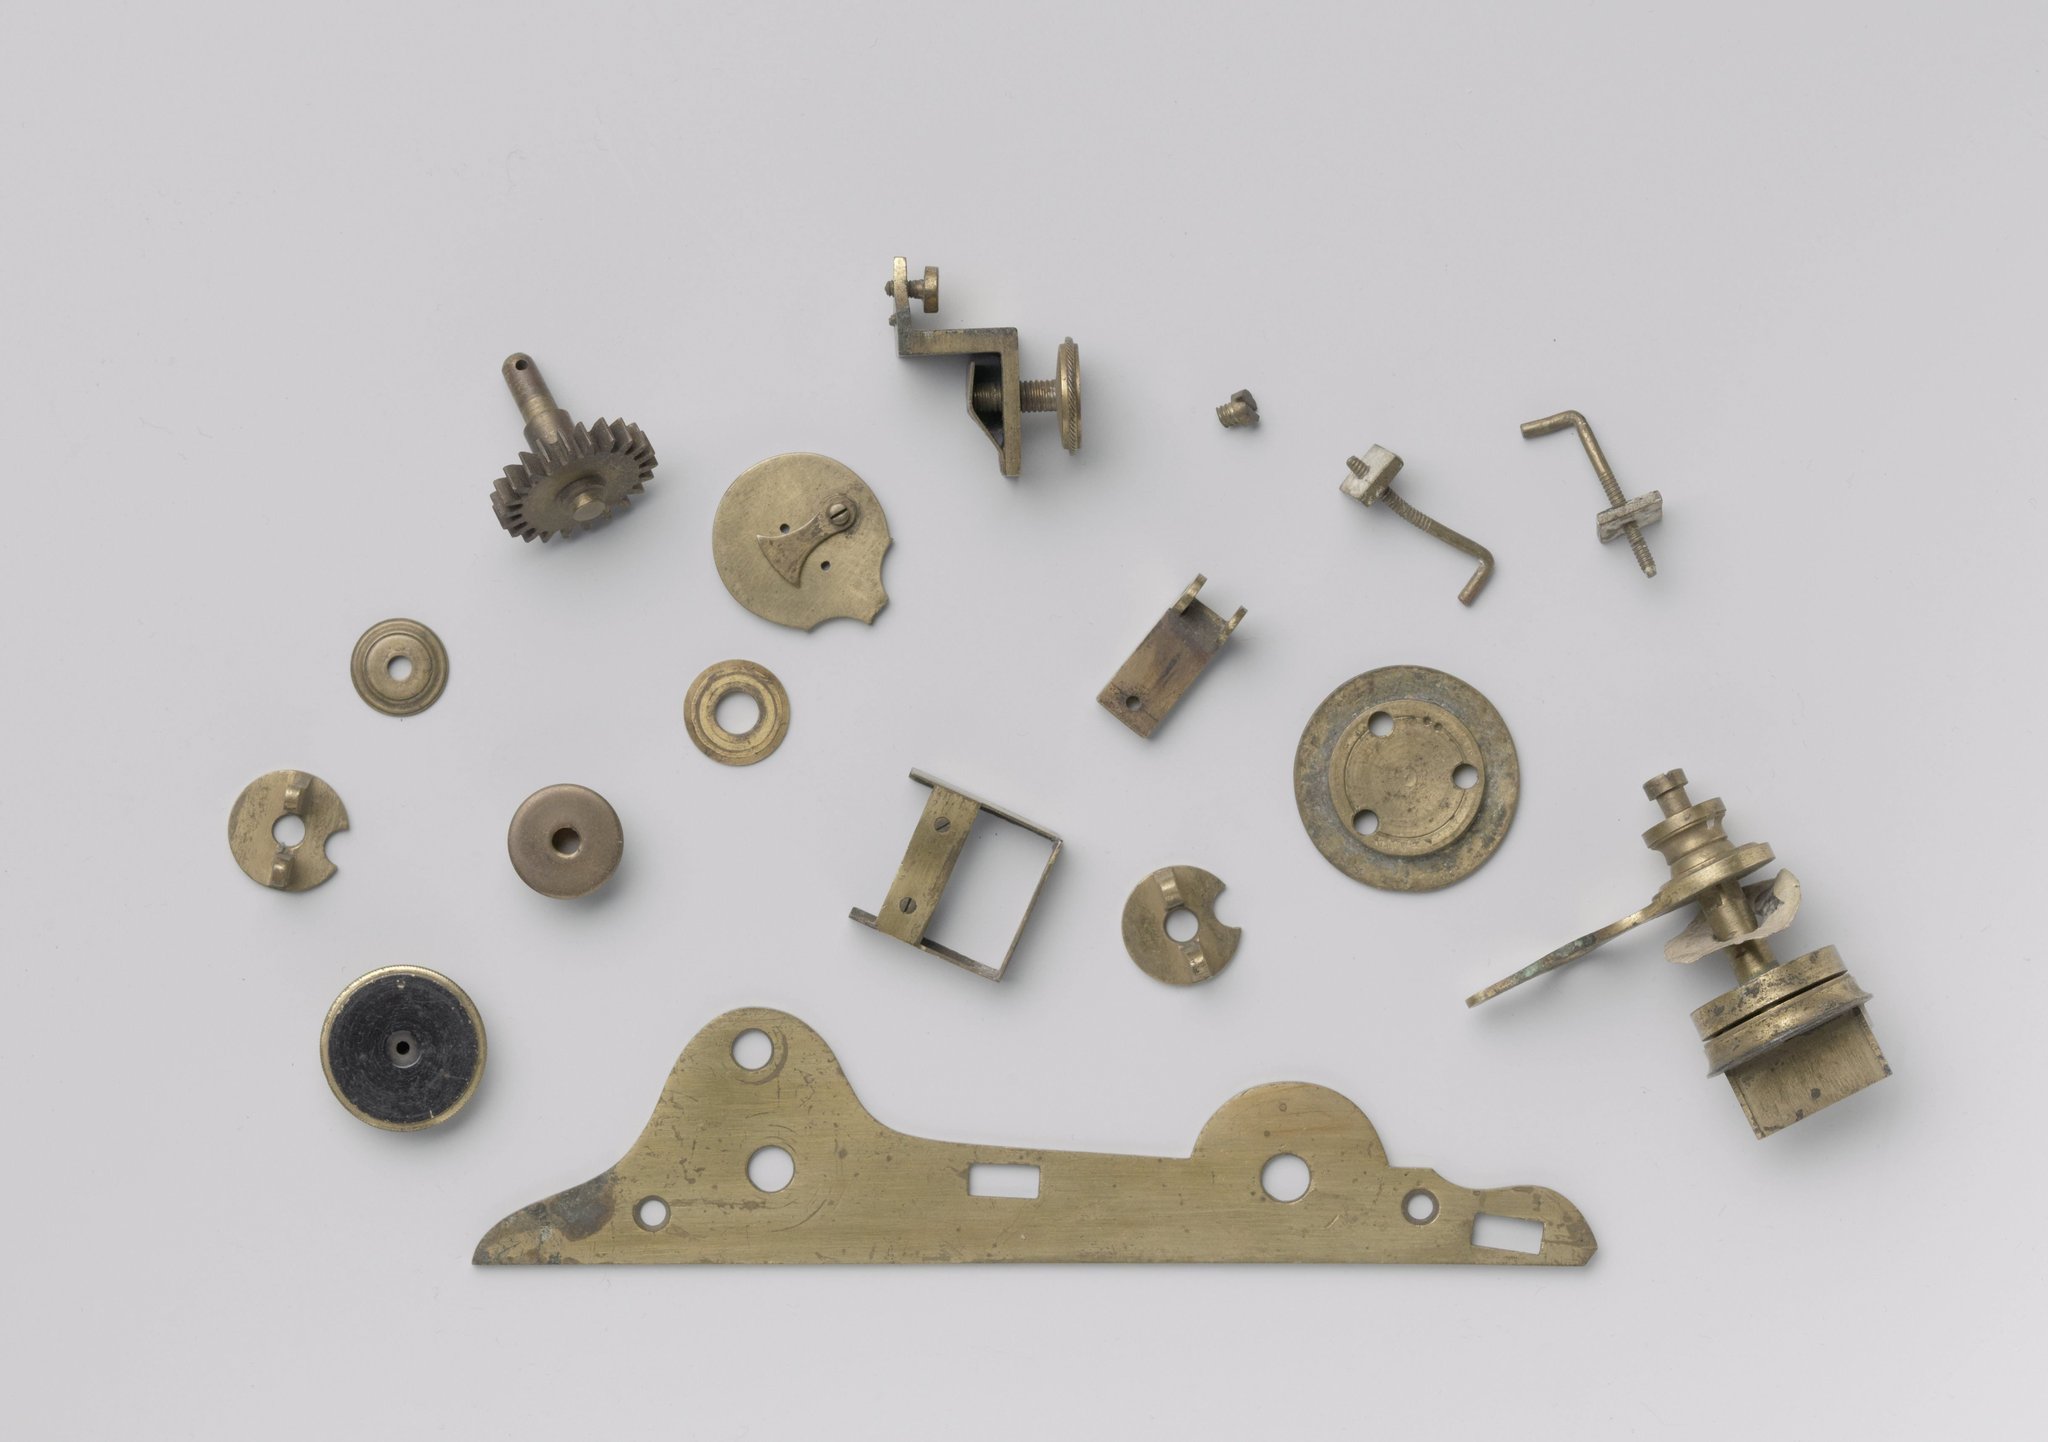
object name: nut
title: Diverse messing onderdelen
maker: Anonymous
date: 1850-1900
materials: brass